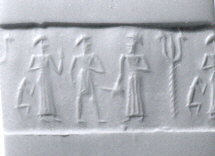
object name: cylinder seal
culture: isin-larsa–old babylonian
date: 2004-1595 BCE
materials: stone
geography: mesopotamia